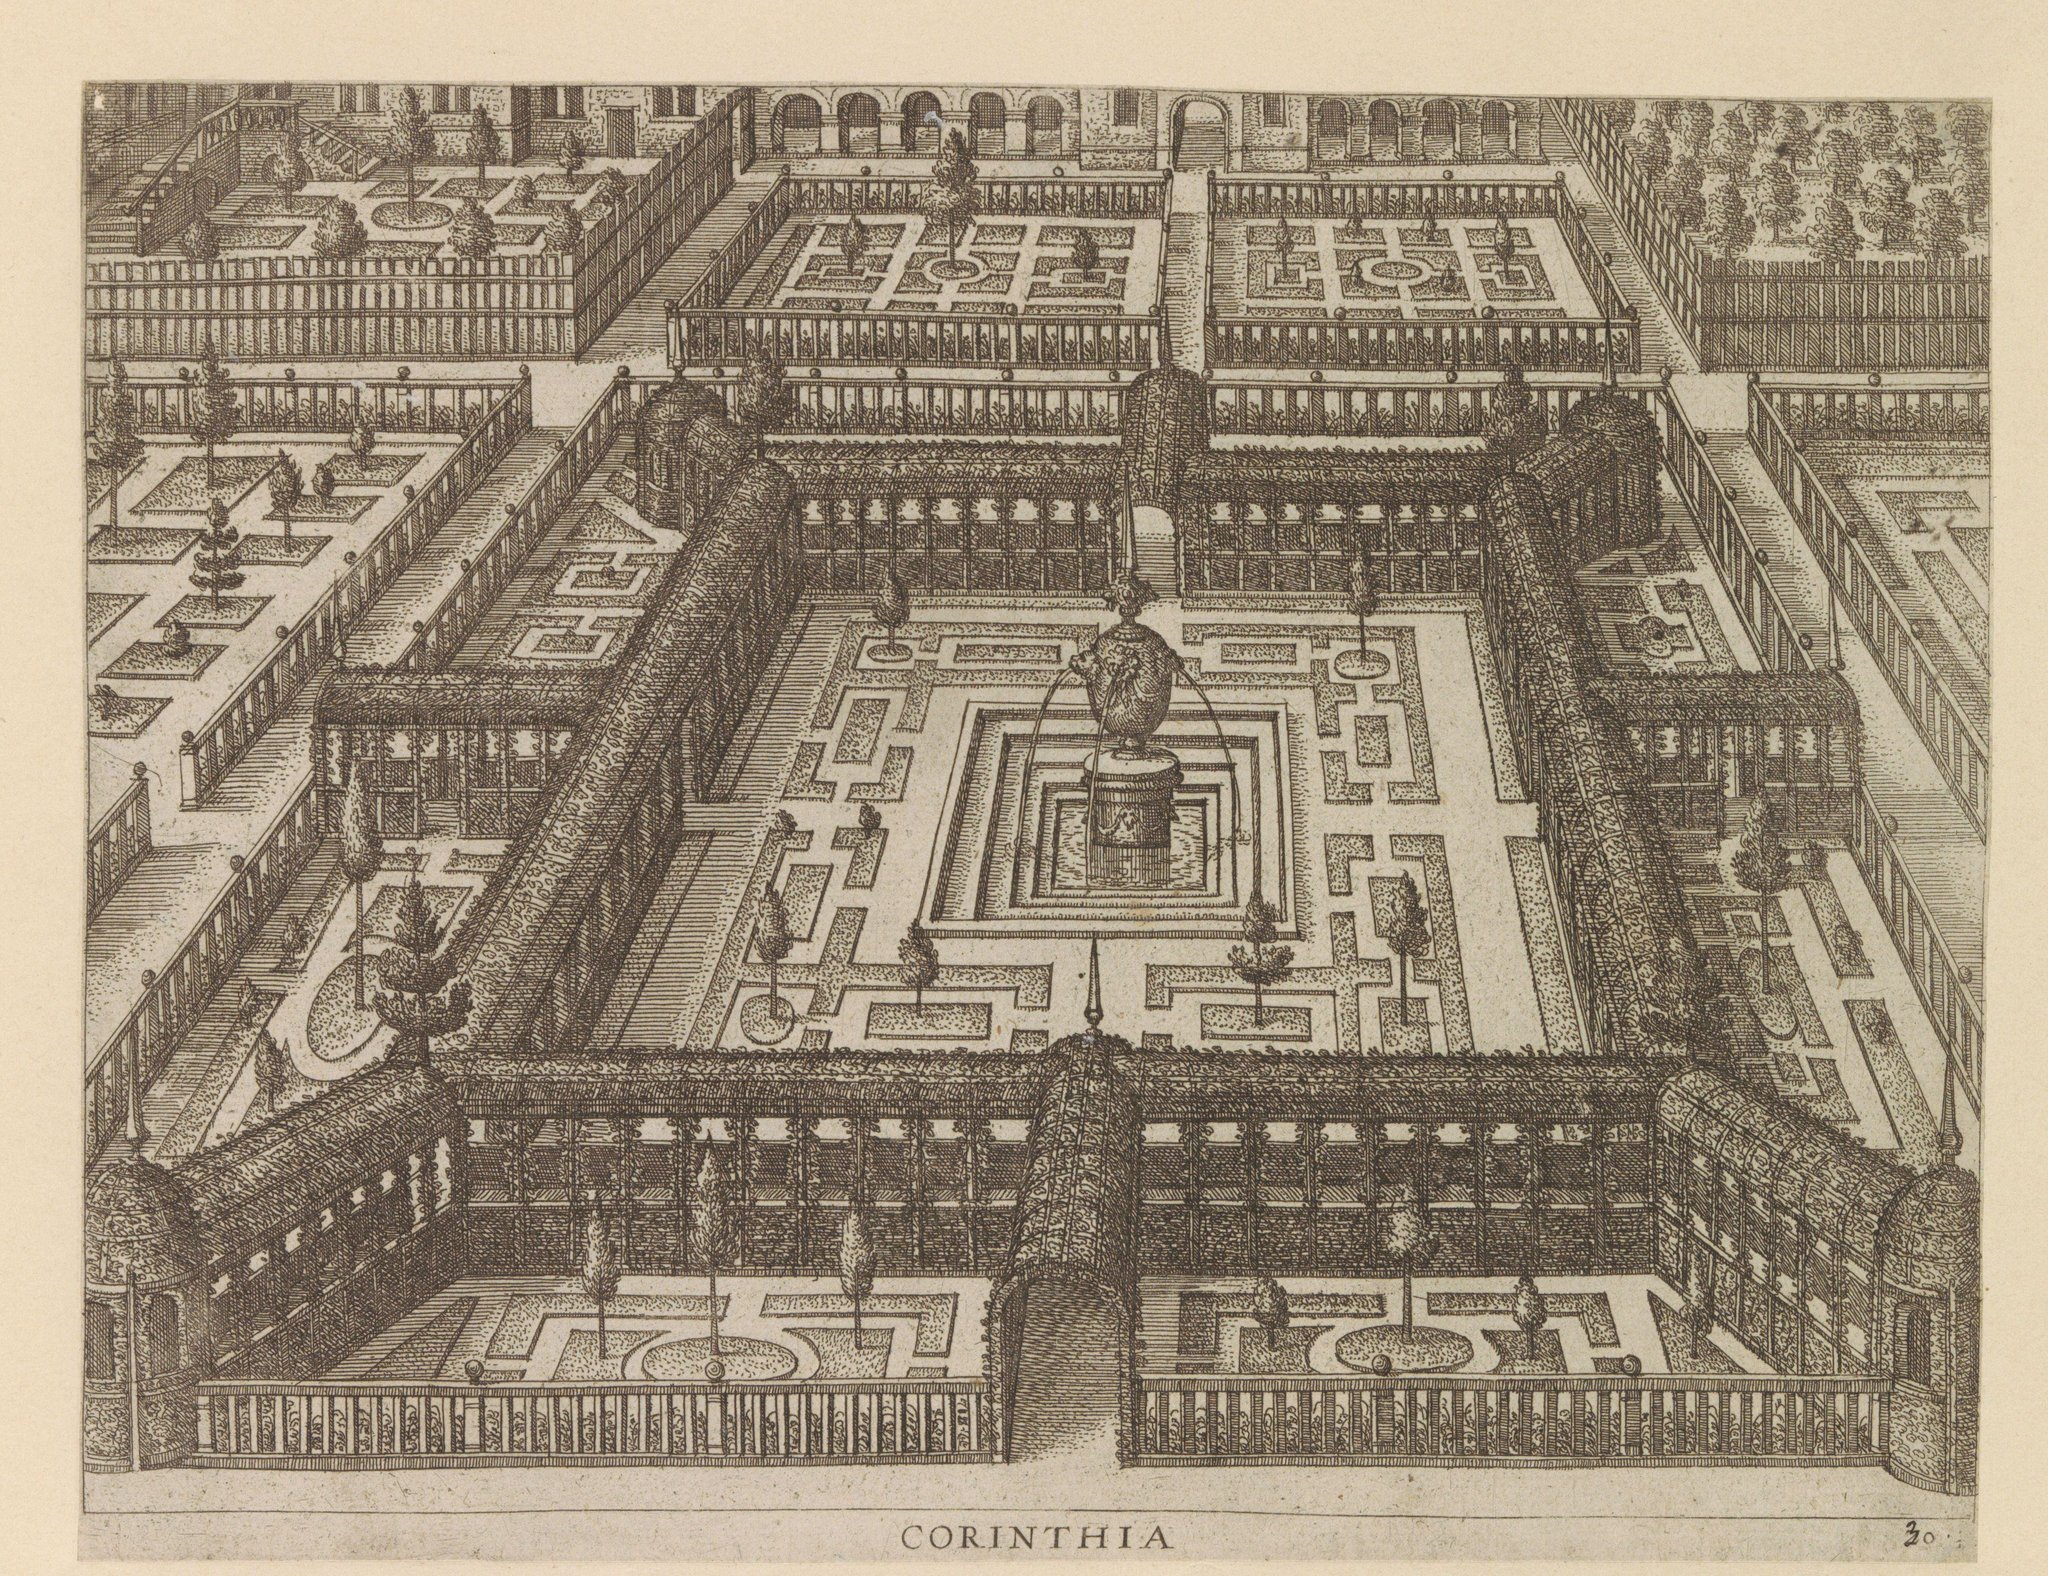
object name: album leaf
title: Corinthia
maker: Anonymous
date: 1583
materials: paper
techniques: etching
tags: garden, french or architectonic garden; formal garden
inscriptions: inscription: ‘3’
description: Tuin met een parterre omgeven door een begroeide gang van traliewerk. In het centrum een fontein met een vaas. De tuin is aangelegd volgens de Korinthische bouworde. De prent maakt deel uit van een album.